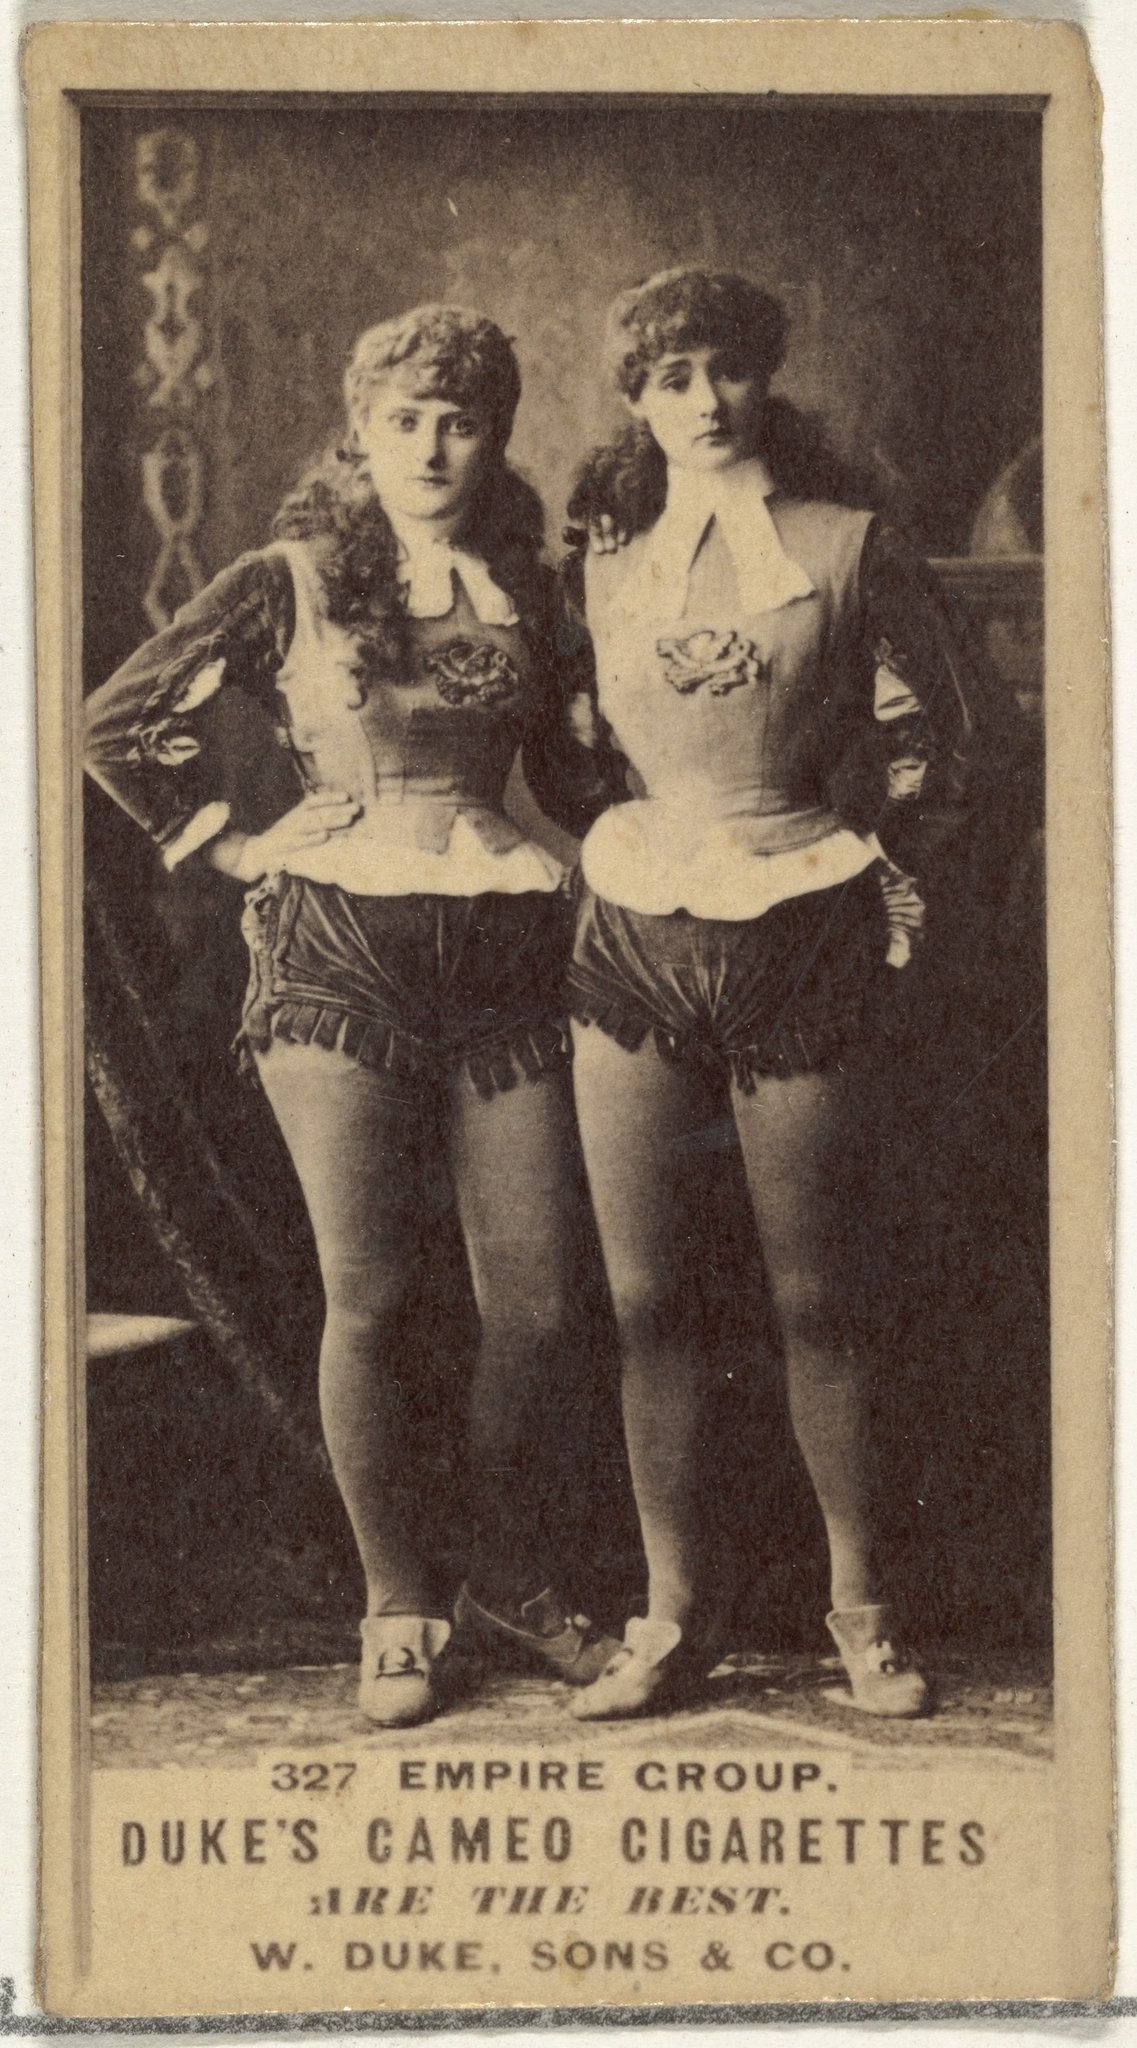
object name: photograph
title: Card Number 327, Empire Group, from the Actors and Actresses series (N145-5) issued by Duke Sons & Co. to promote Cameo Cigarettes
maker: w. duke, sons & co.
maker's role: publisher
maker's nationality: american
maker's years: 1870-1920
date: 1880-1889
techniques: albumen silver print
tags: portraits,women,actresses